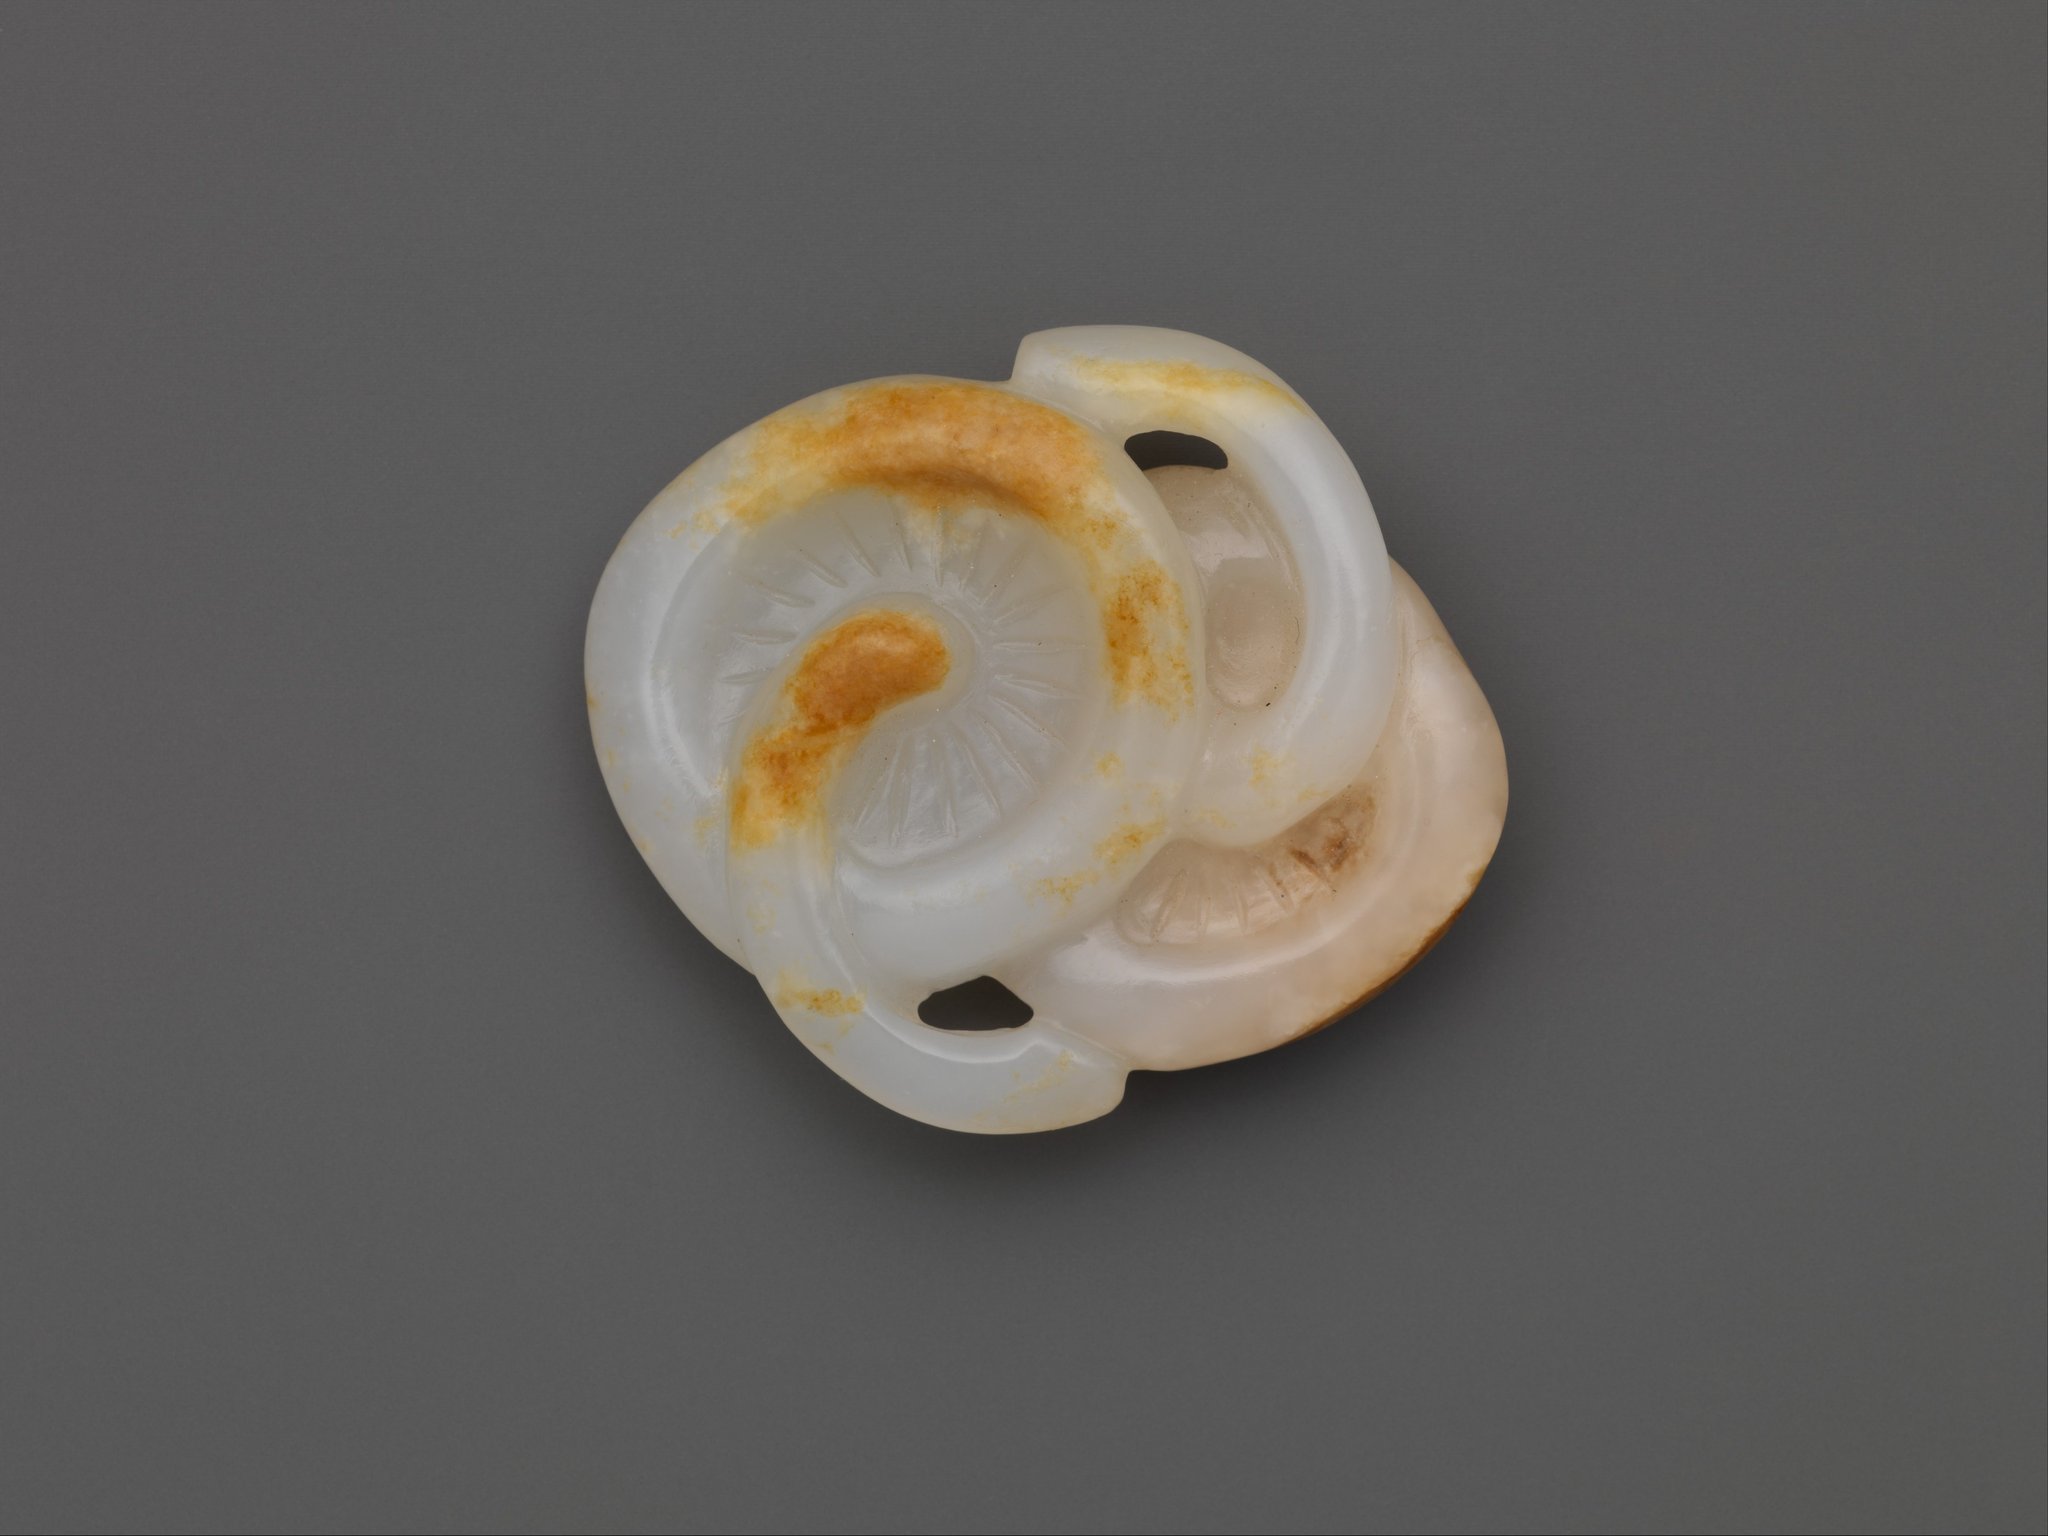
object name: ornament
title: Lingzhi mushrooms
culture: chinese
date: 1701-1800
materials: jade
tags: food